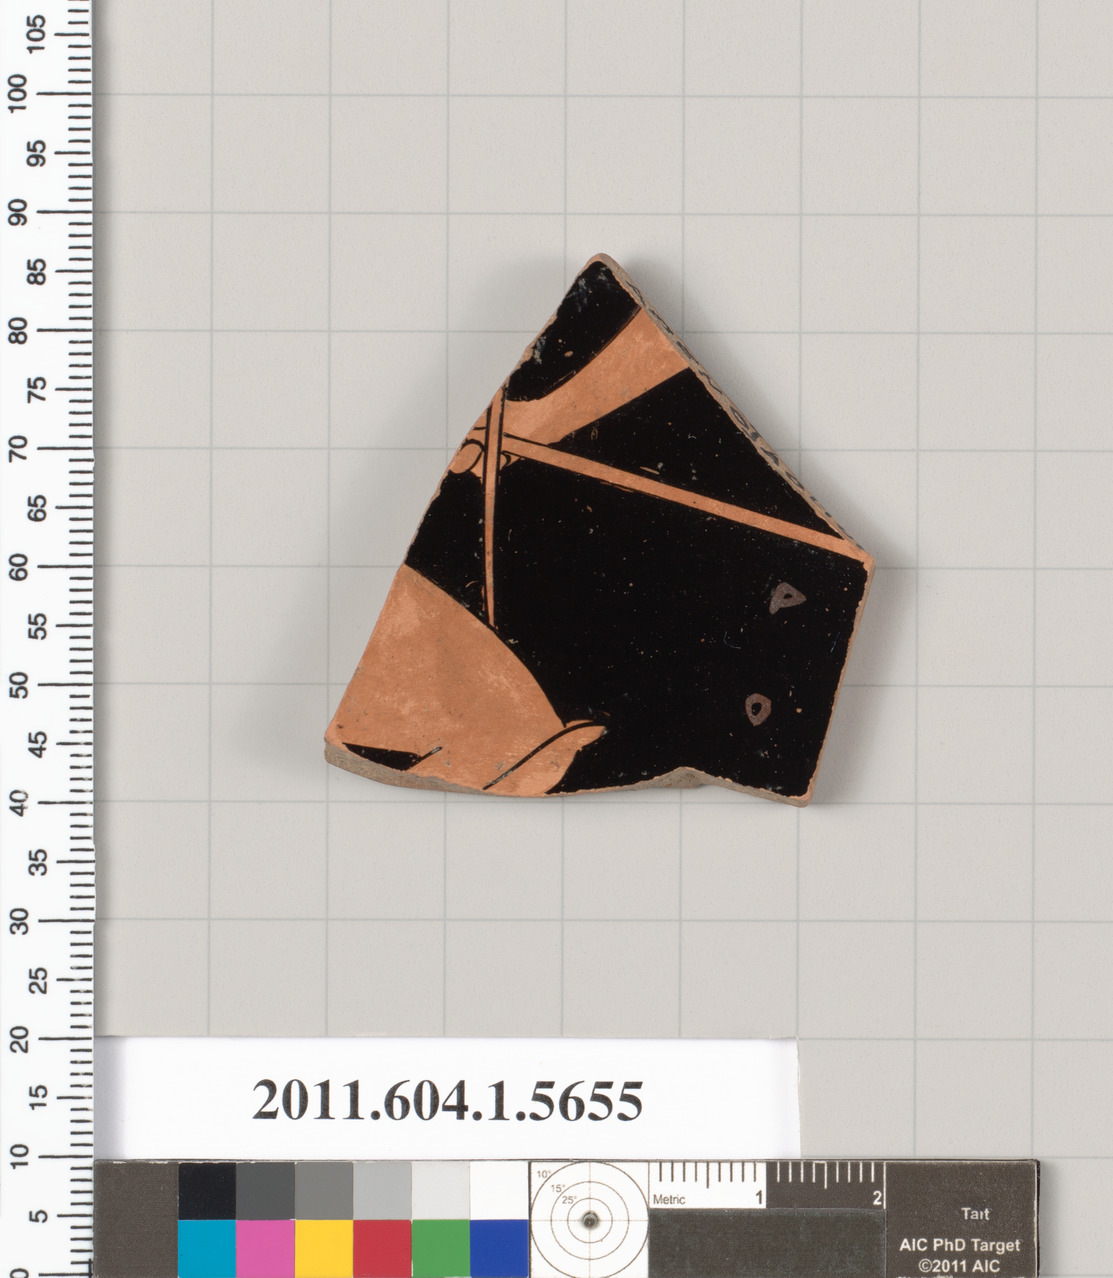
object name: kylix fragment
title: Terracotta fragment of a kylix (drinking cup)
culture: greek, attic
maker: onesimos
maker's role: artist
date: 490-480 BCE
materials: terracotta